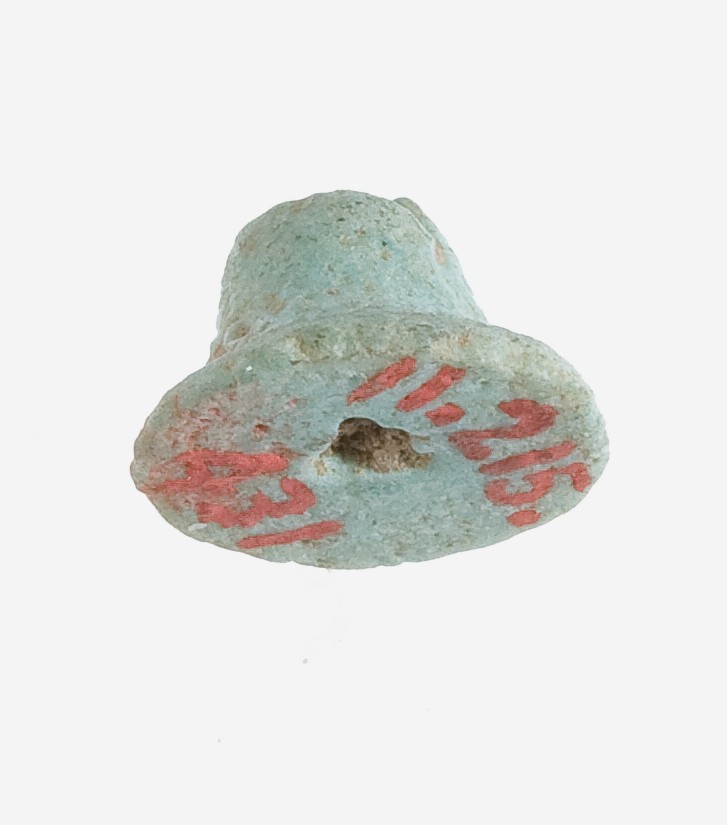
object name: pendant, umbel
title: Umbel Pendant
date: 1390-1352 BCE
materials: faience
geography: egypt